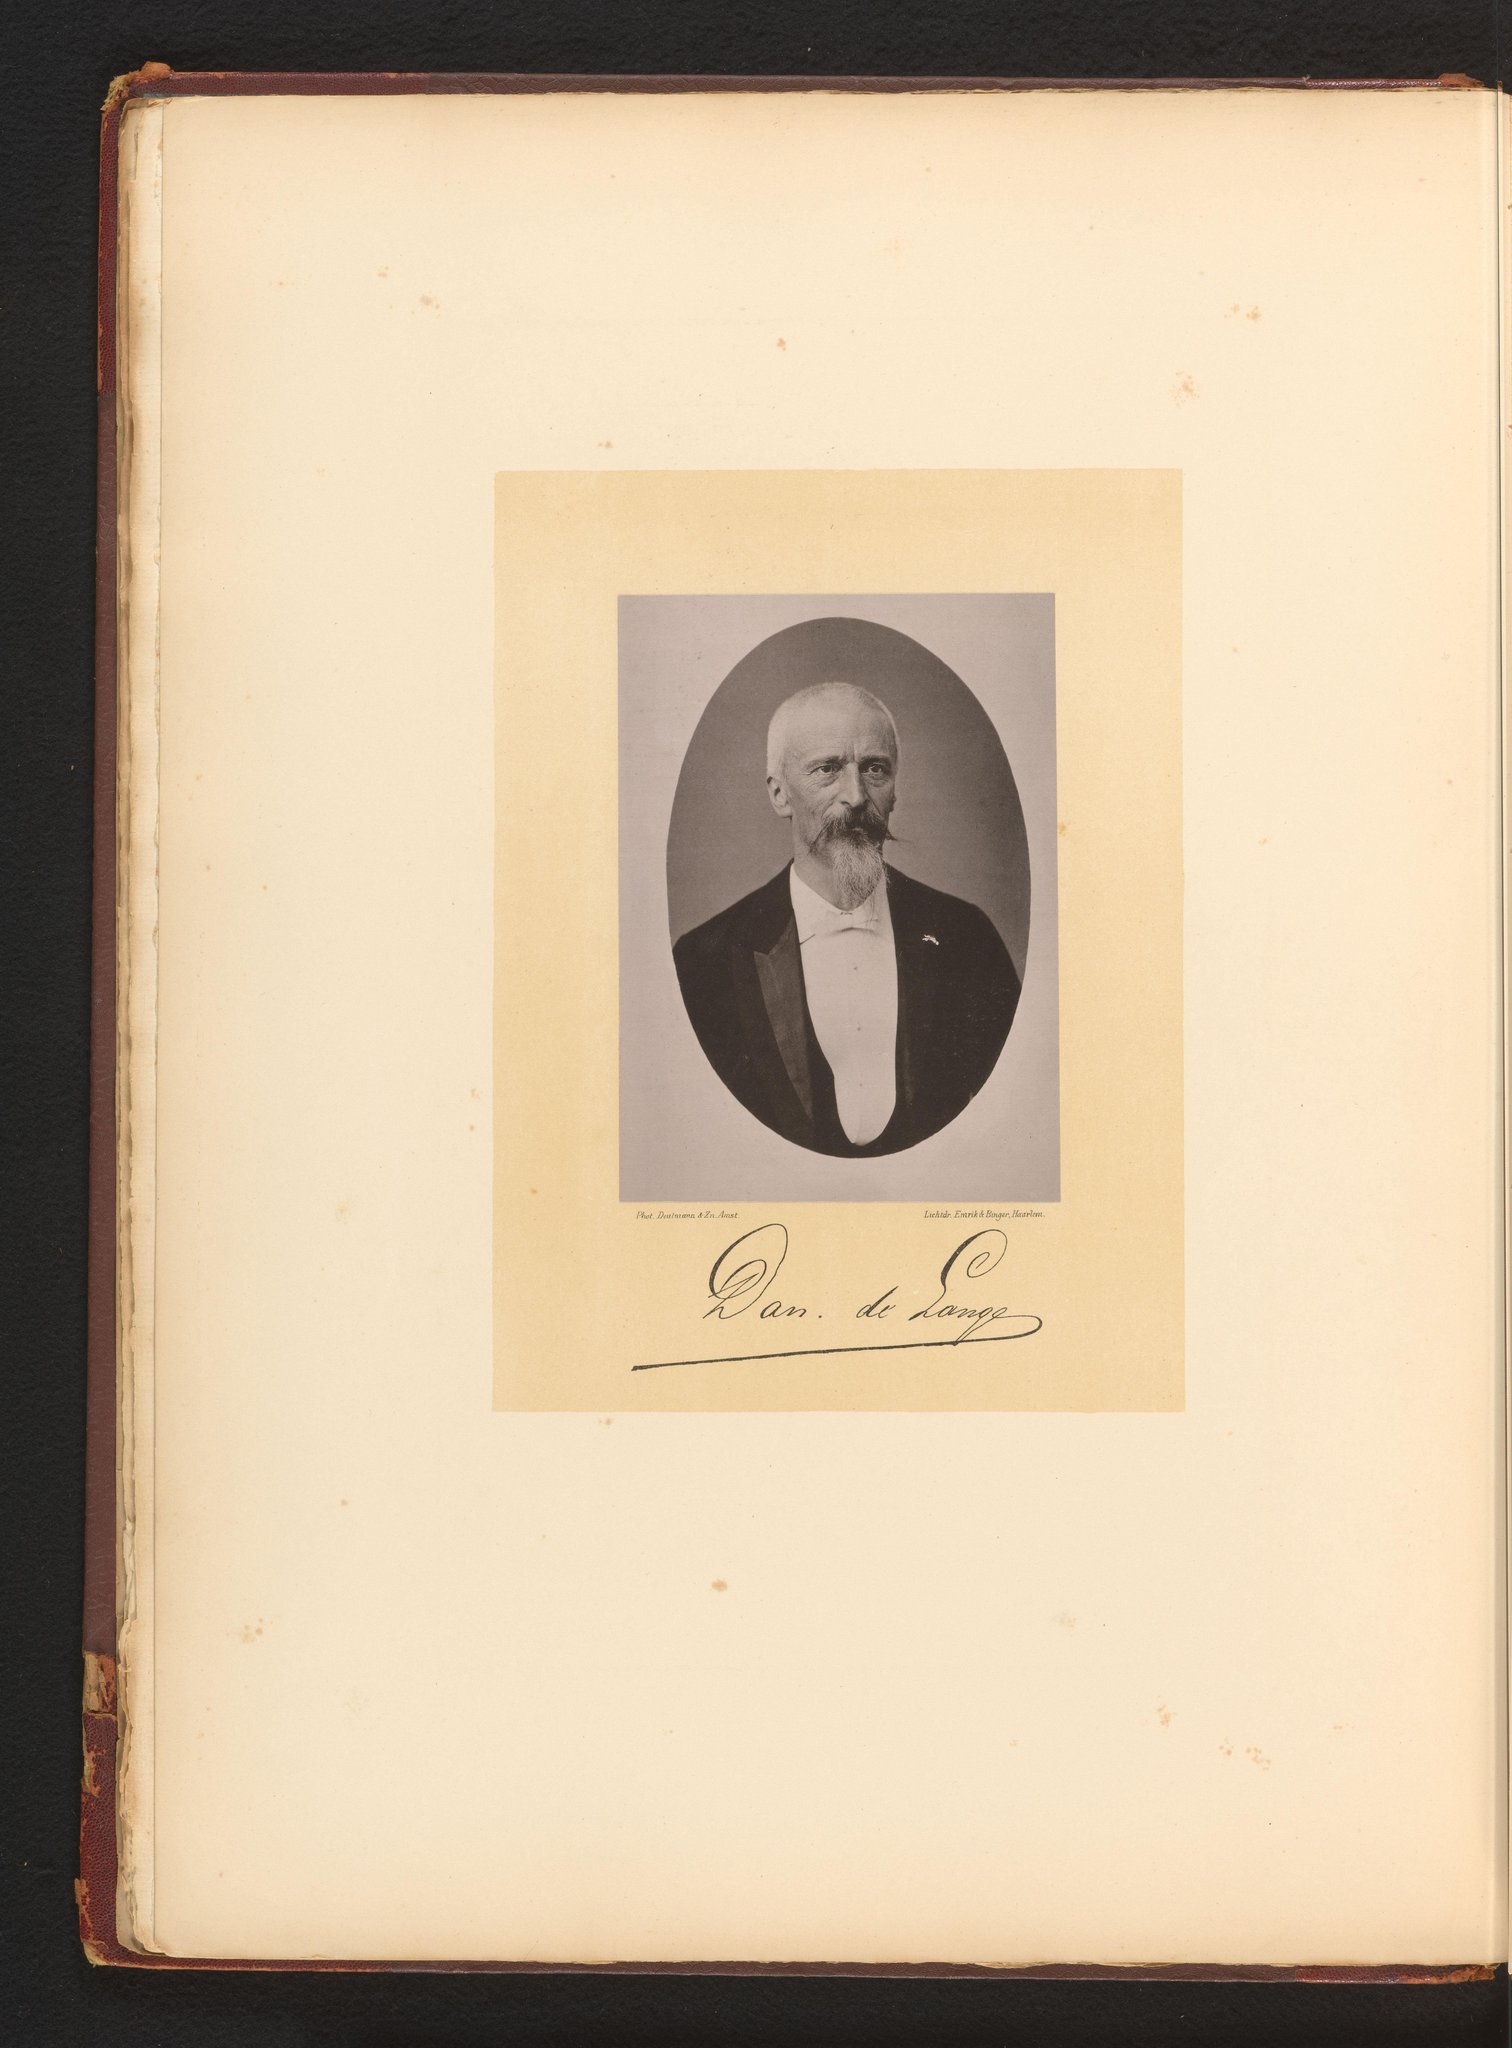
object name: page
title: Dan. de Lange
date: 1888-1896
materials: paper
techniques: photograph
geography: amsterdam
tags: historical persons, portrait of a musician